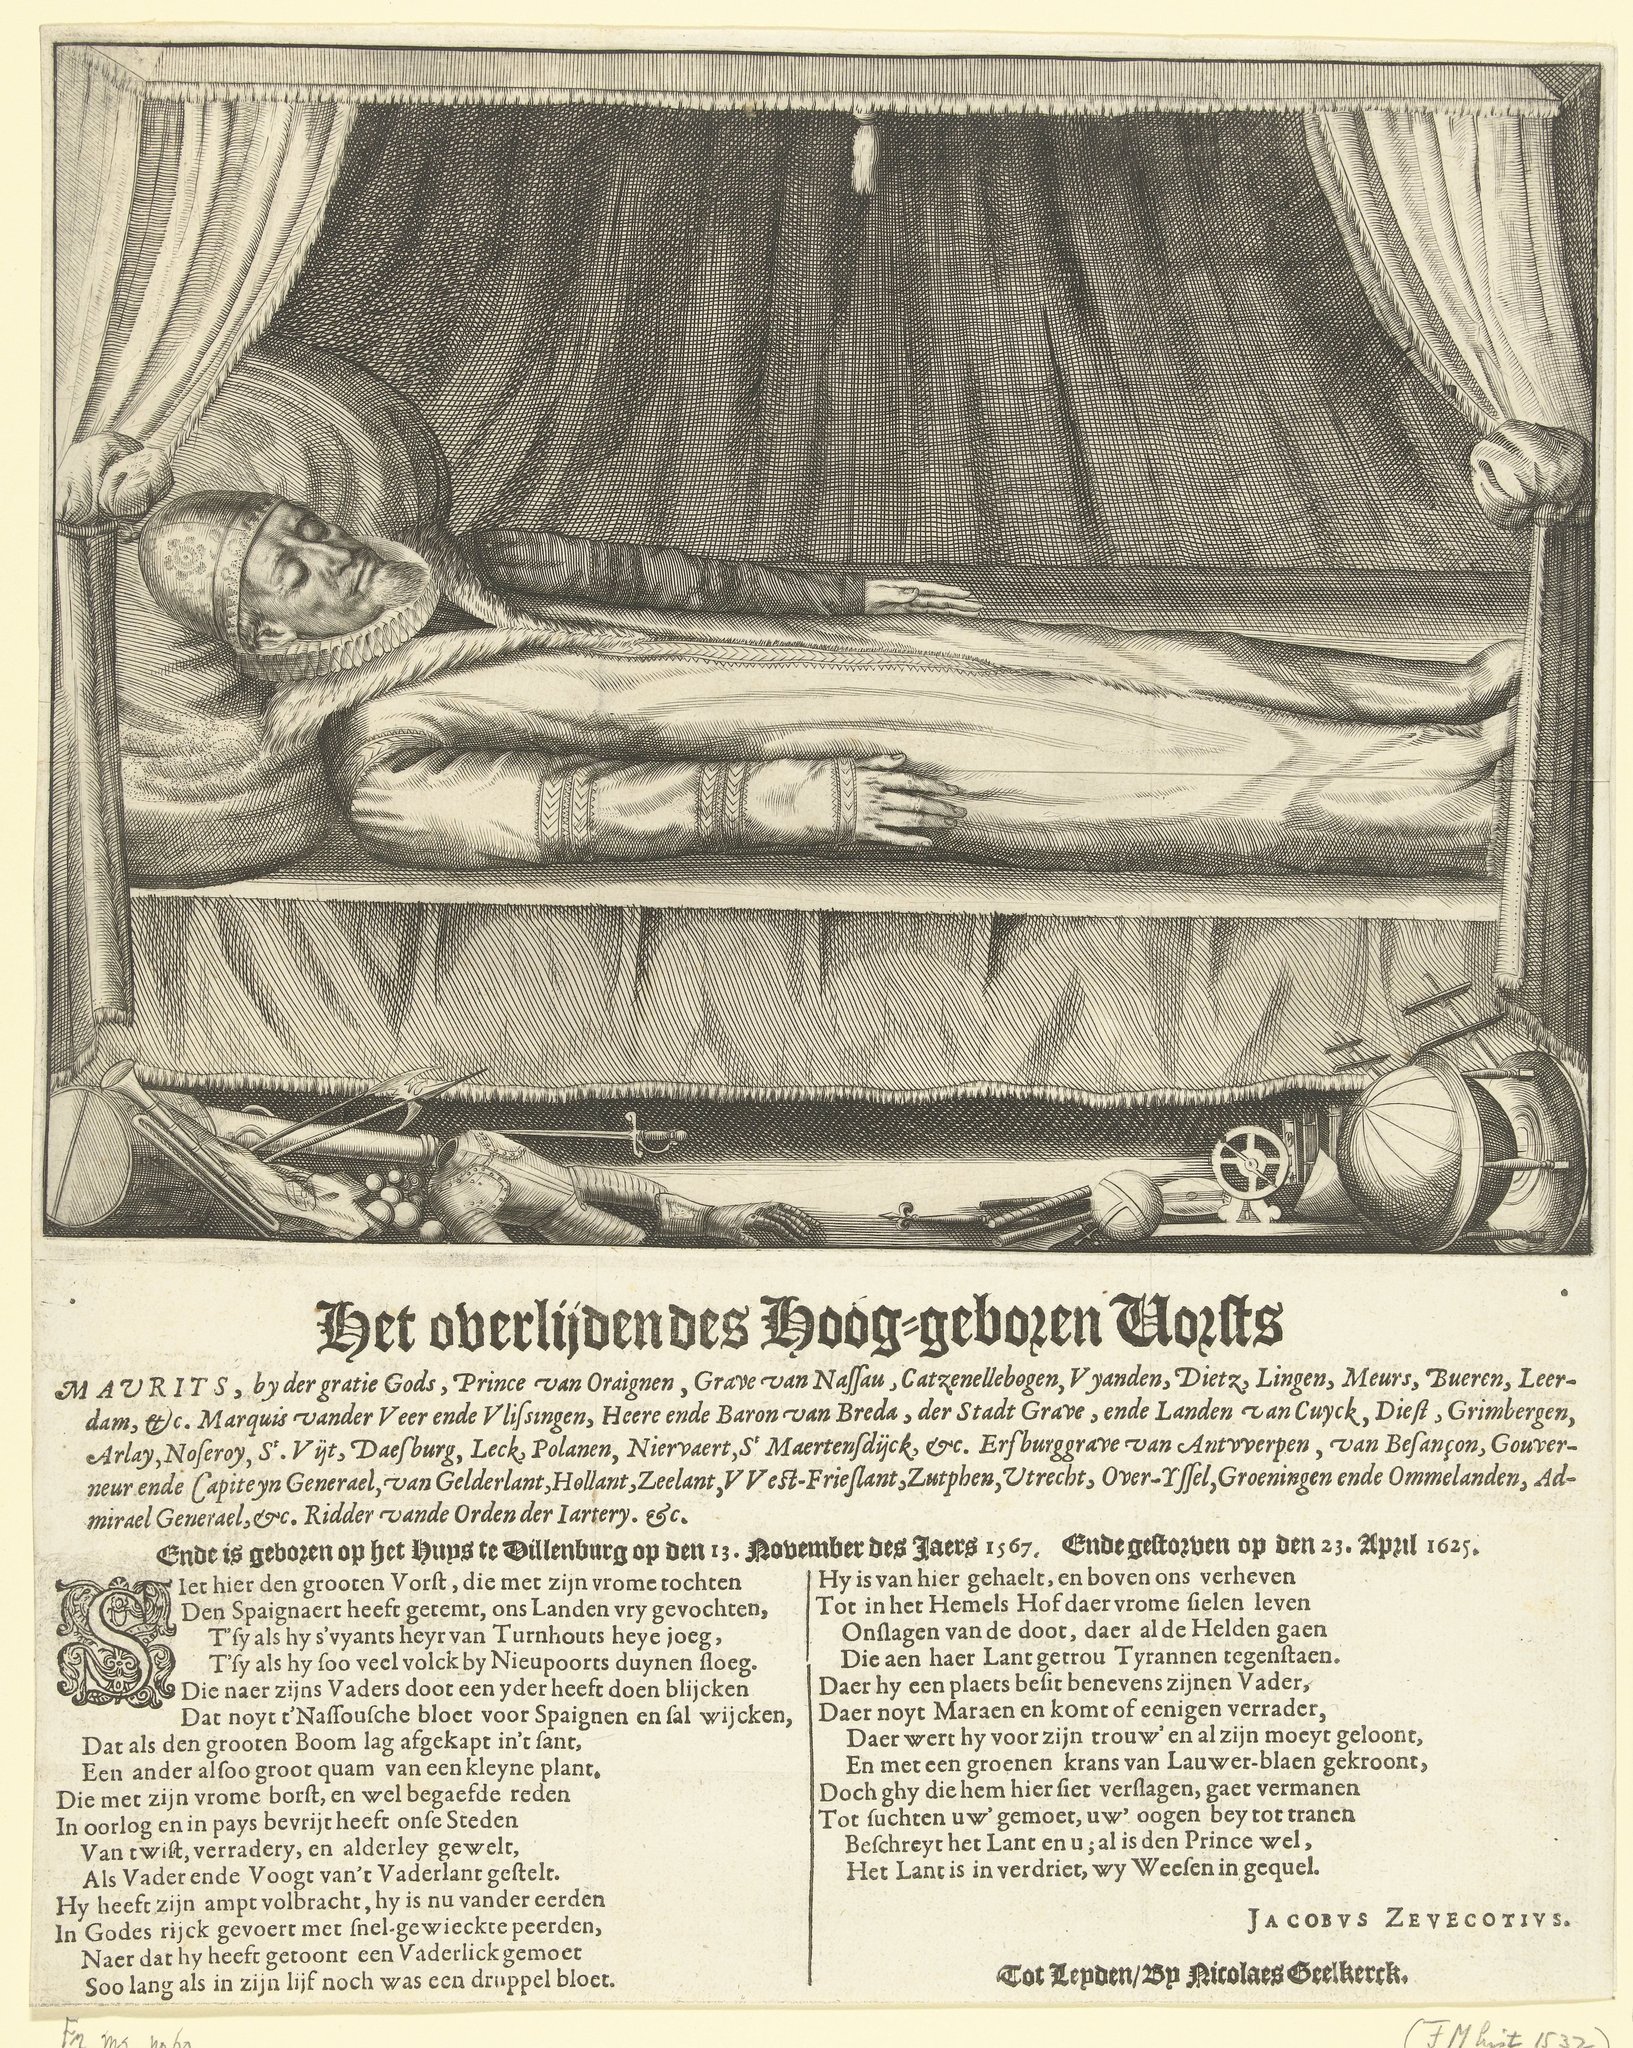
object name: print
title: Praalbed van Maurits, prins van Oranje, 1625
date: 1625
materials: paper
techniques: engraving, letterpress printing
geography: leiden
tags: maurice (prince of orange), lying in state, the hague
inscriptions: collector's mark: Lugt 963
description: De hier vermelde titel verwijst naar de hoogst verkregen titel van de geportretteerde, niet per se naar de titel die de geportretteerde op deze voorstelling draagt. Waarschijnlijk heeft Muller bij de beschrijvingen van de nrs. FMH 1531 en 1532 twee prenten door elkaar gehaald. De prent heeft specifieke elementen uit beide nummers. In de beschrijving van FMH 1532 zitten echter ook details die niet op de prent voorkomen, zoals de grote zaal, Fama boven het bed en het praalbed zonder gordijnen.